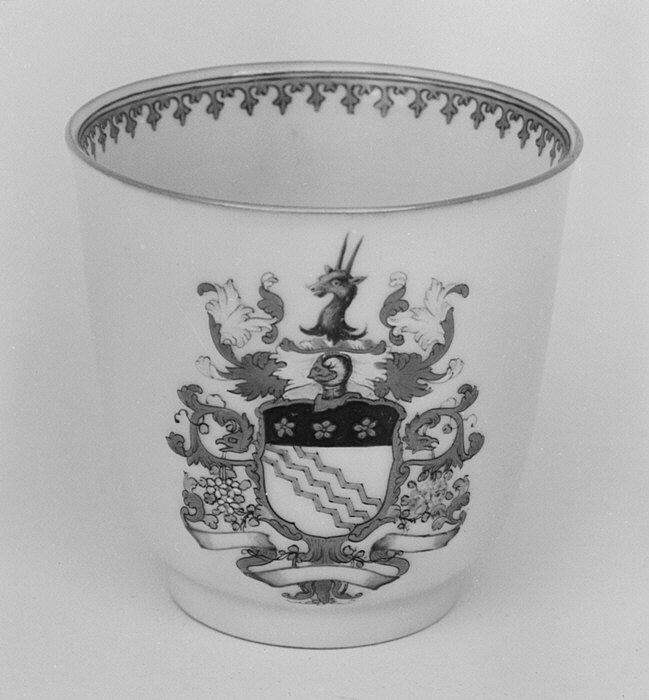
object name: cup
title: Cup (part of a service)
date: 1750-1760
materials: hard paste porcelain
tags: coat of arms